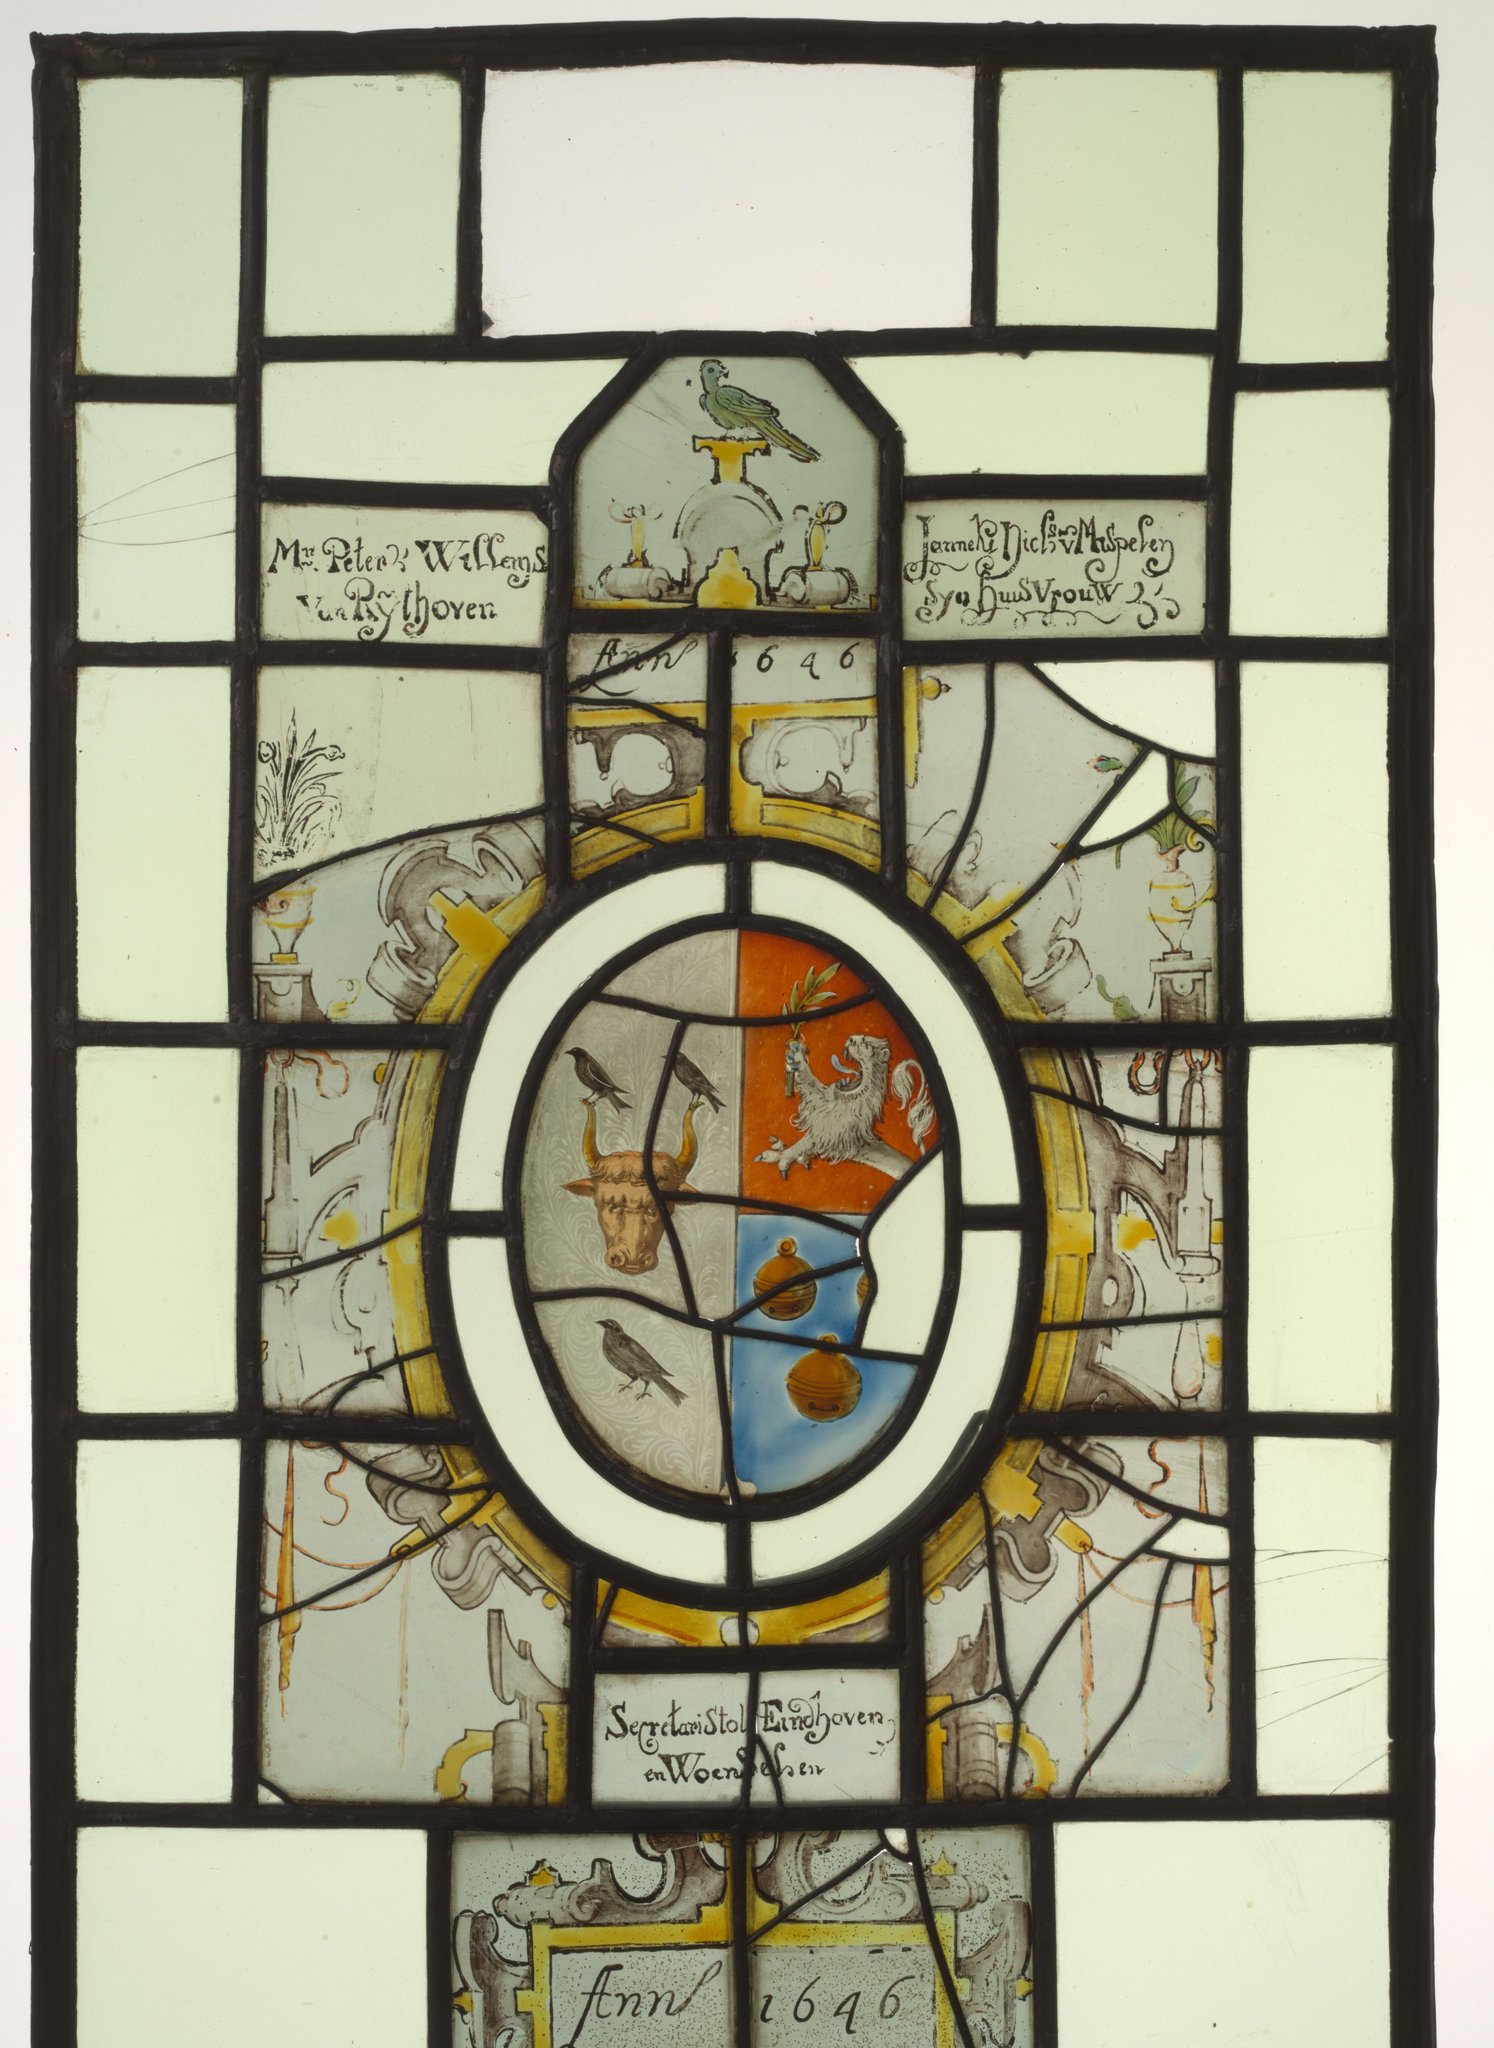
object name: wapenruit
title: Ruit met wapen waarin een ossenkop, vogels, bellen en een klimmende leeuw en inscripties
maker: Anonymous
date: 1646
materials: glass, lead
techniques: leading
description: Paneel met diverse beschreven of beschilderde ruiten. In het midden een ovale ruit met een wapen waarin o.a. een ossenkop, drie vogels en drie bellen en onderschrift o.a. "Mr Pieter Willems van Rythoven, Janneke Niehs v. Mispelen syn huisvrouw, Secretaris tot Eindhoven en Woenselen Anno 1646".